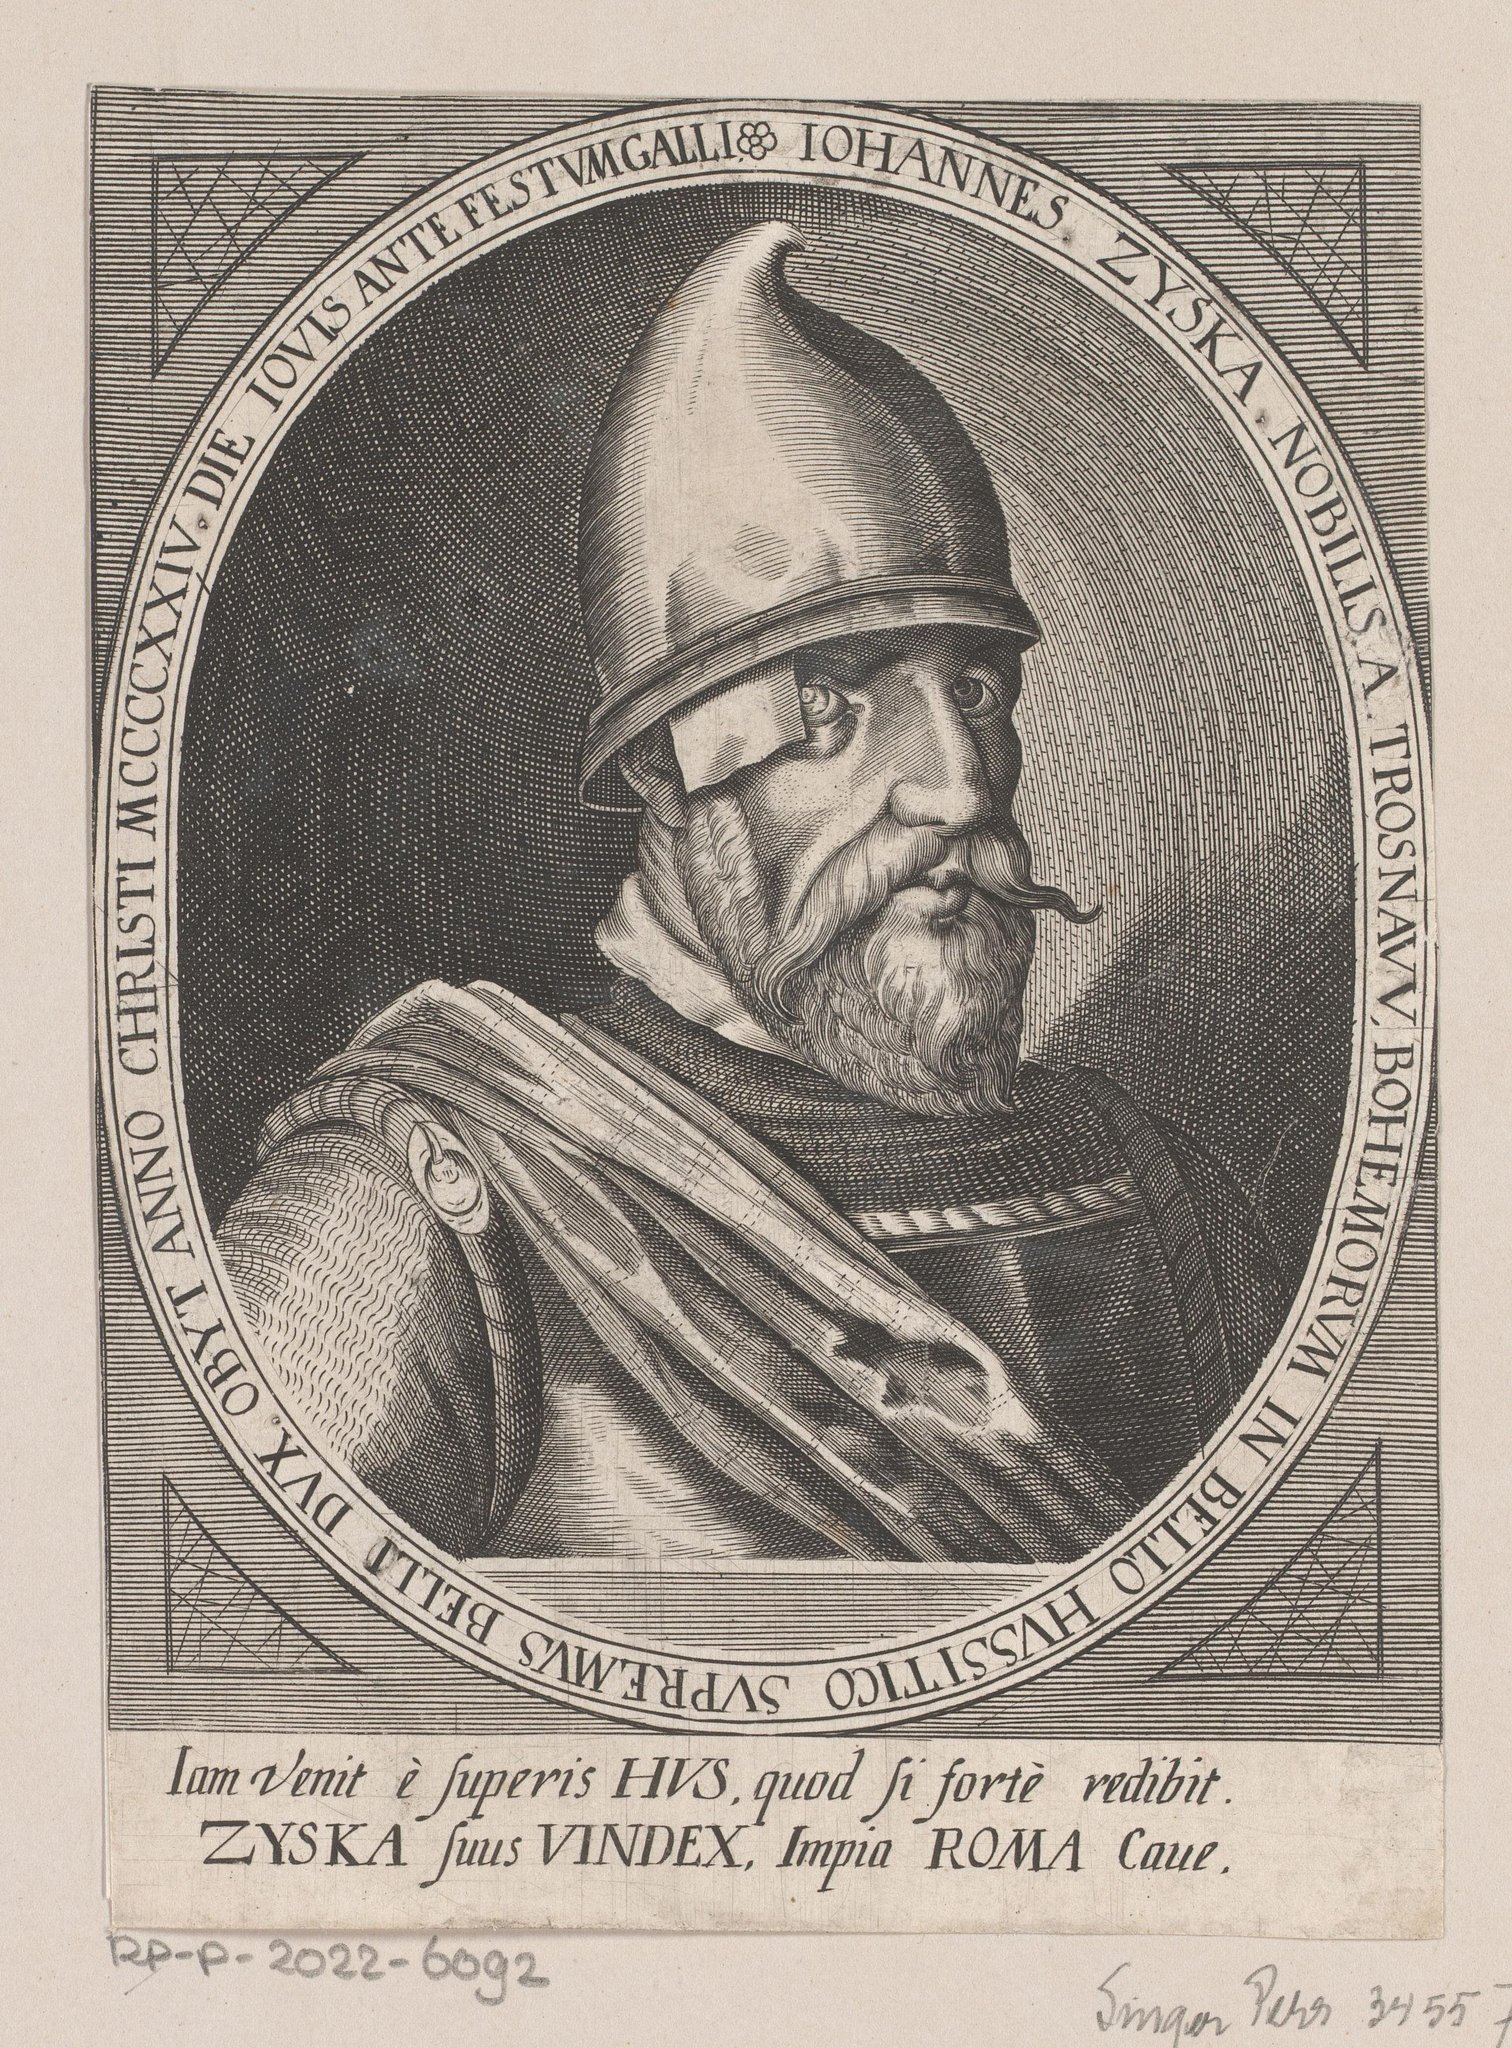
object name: print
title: Portret van Jan Zizka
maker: Anonymous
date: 1624-1670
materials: paper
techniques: engraving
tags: commander-in-chief, general, marshal, historical persons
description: Met tweeregelig onderschrift in het Latijn en tekst in het Latijn rondom het portret.